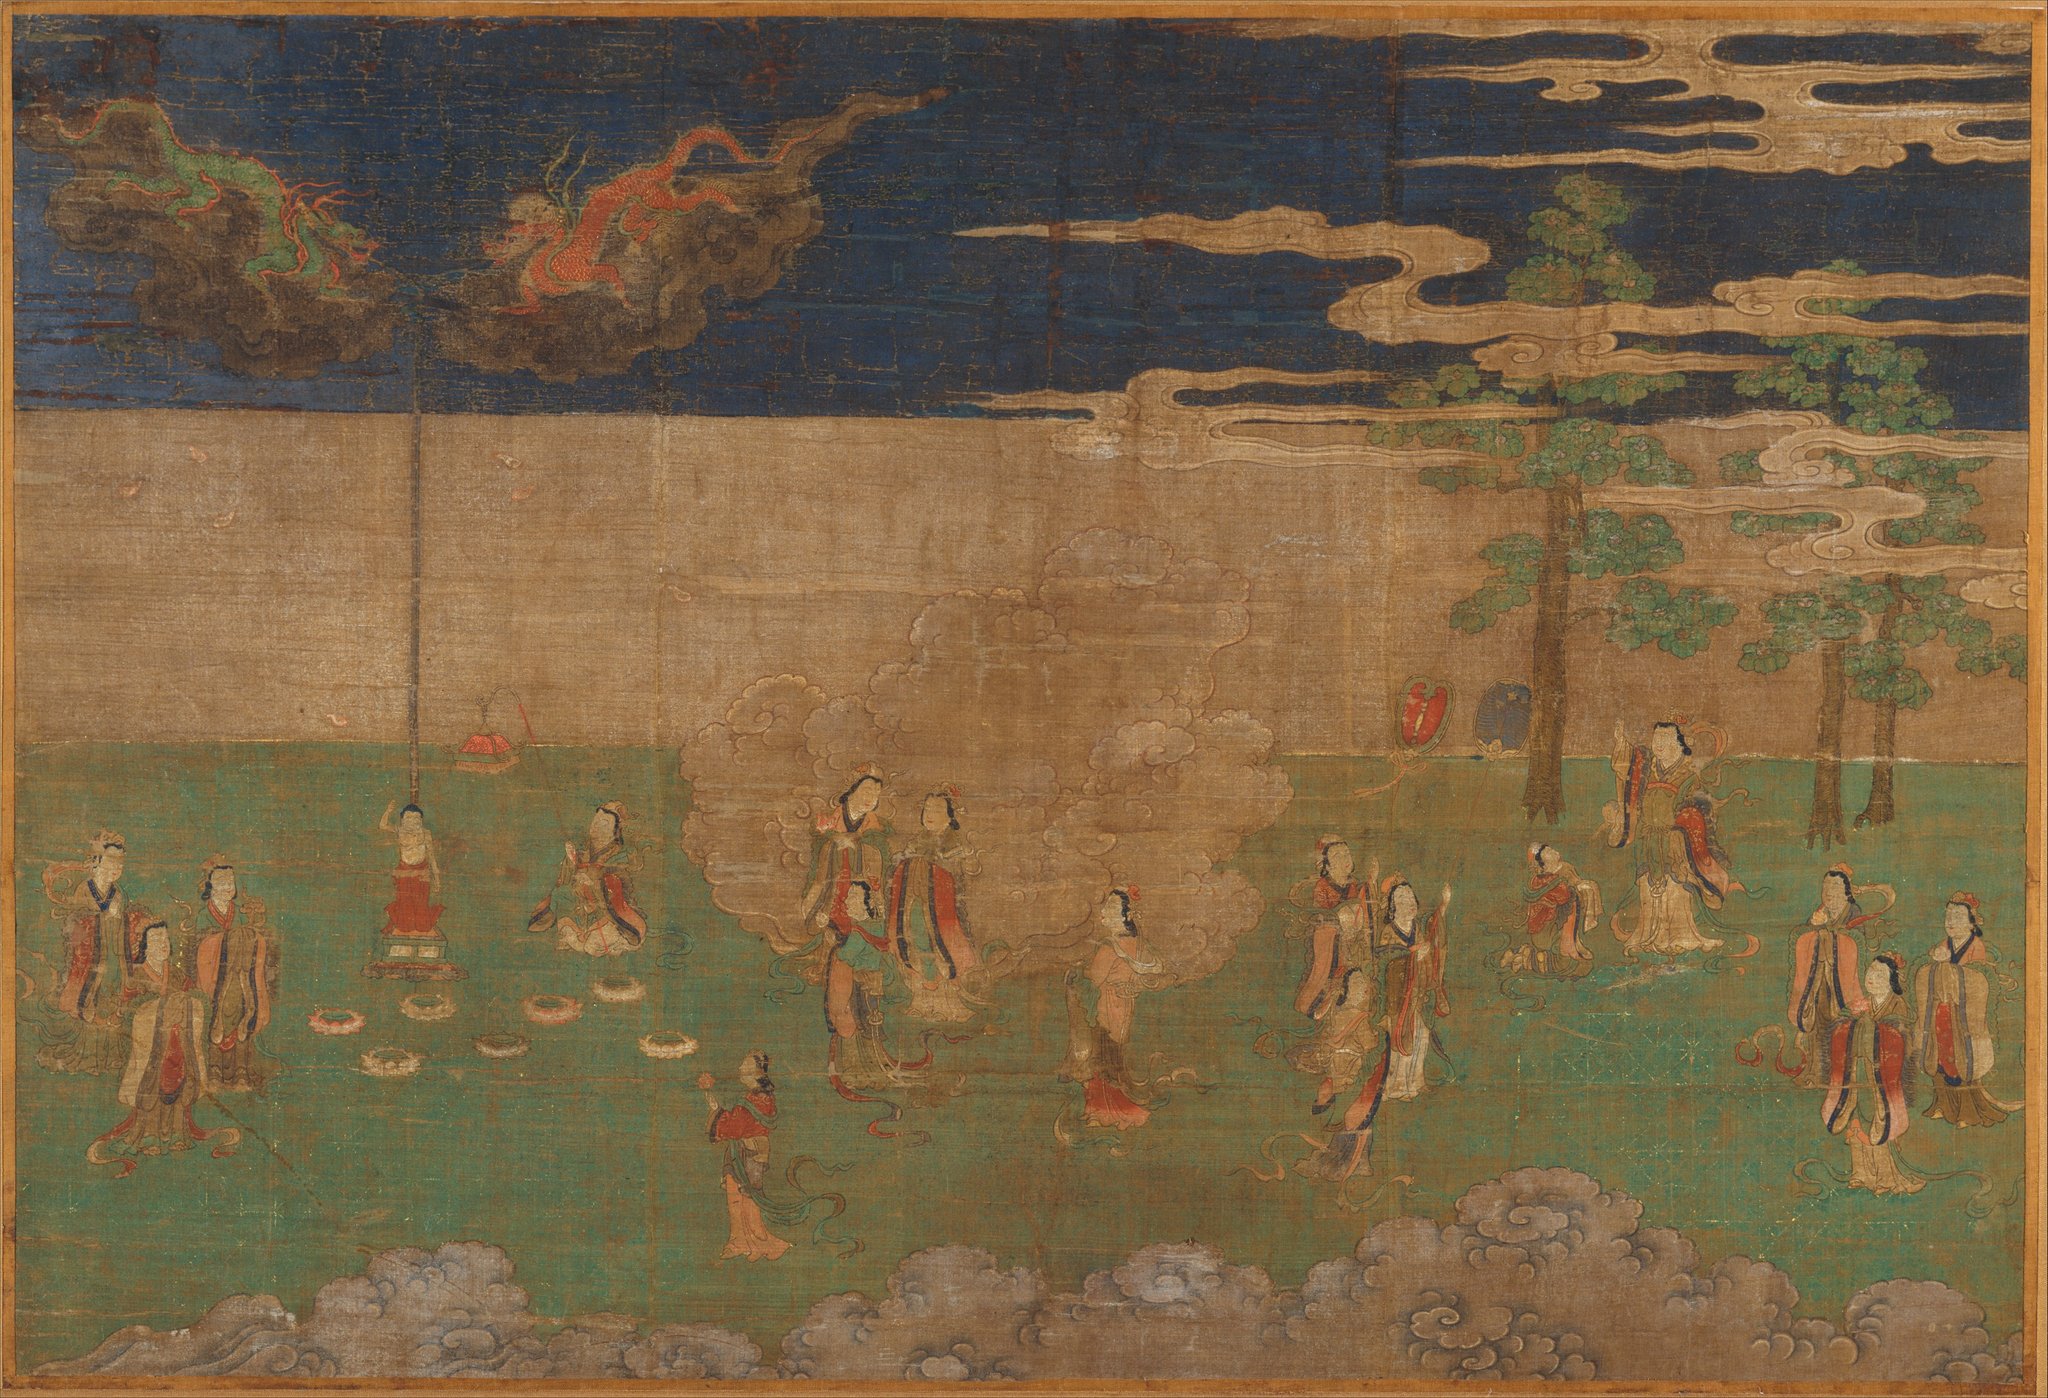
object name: hanging scroll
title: Scene from the Life of the Buddha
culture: japanese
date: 1401-1433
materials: gold, ink, panel, silk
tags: gardens,dragons,buddha,musicians